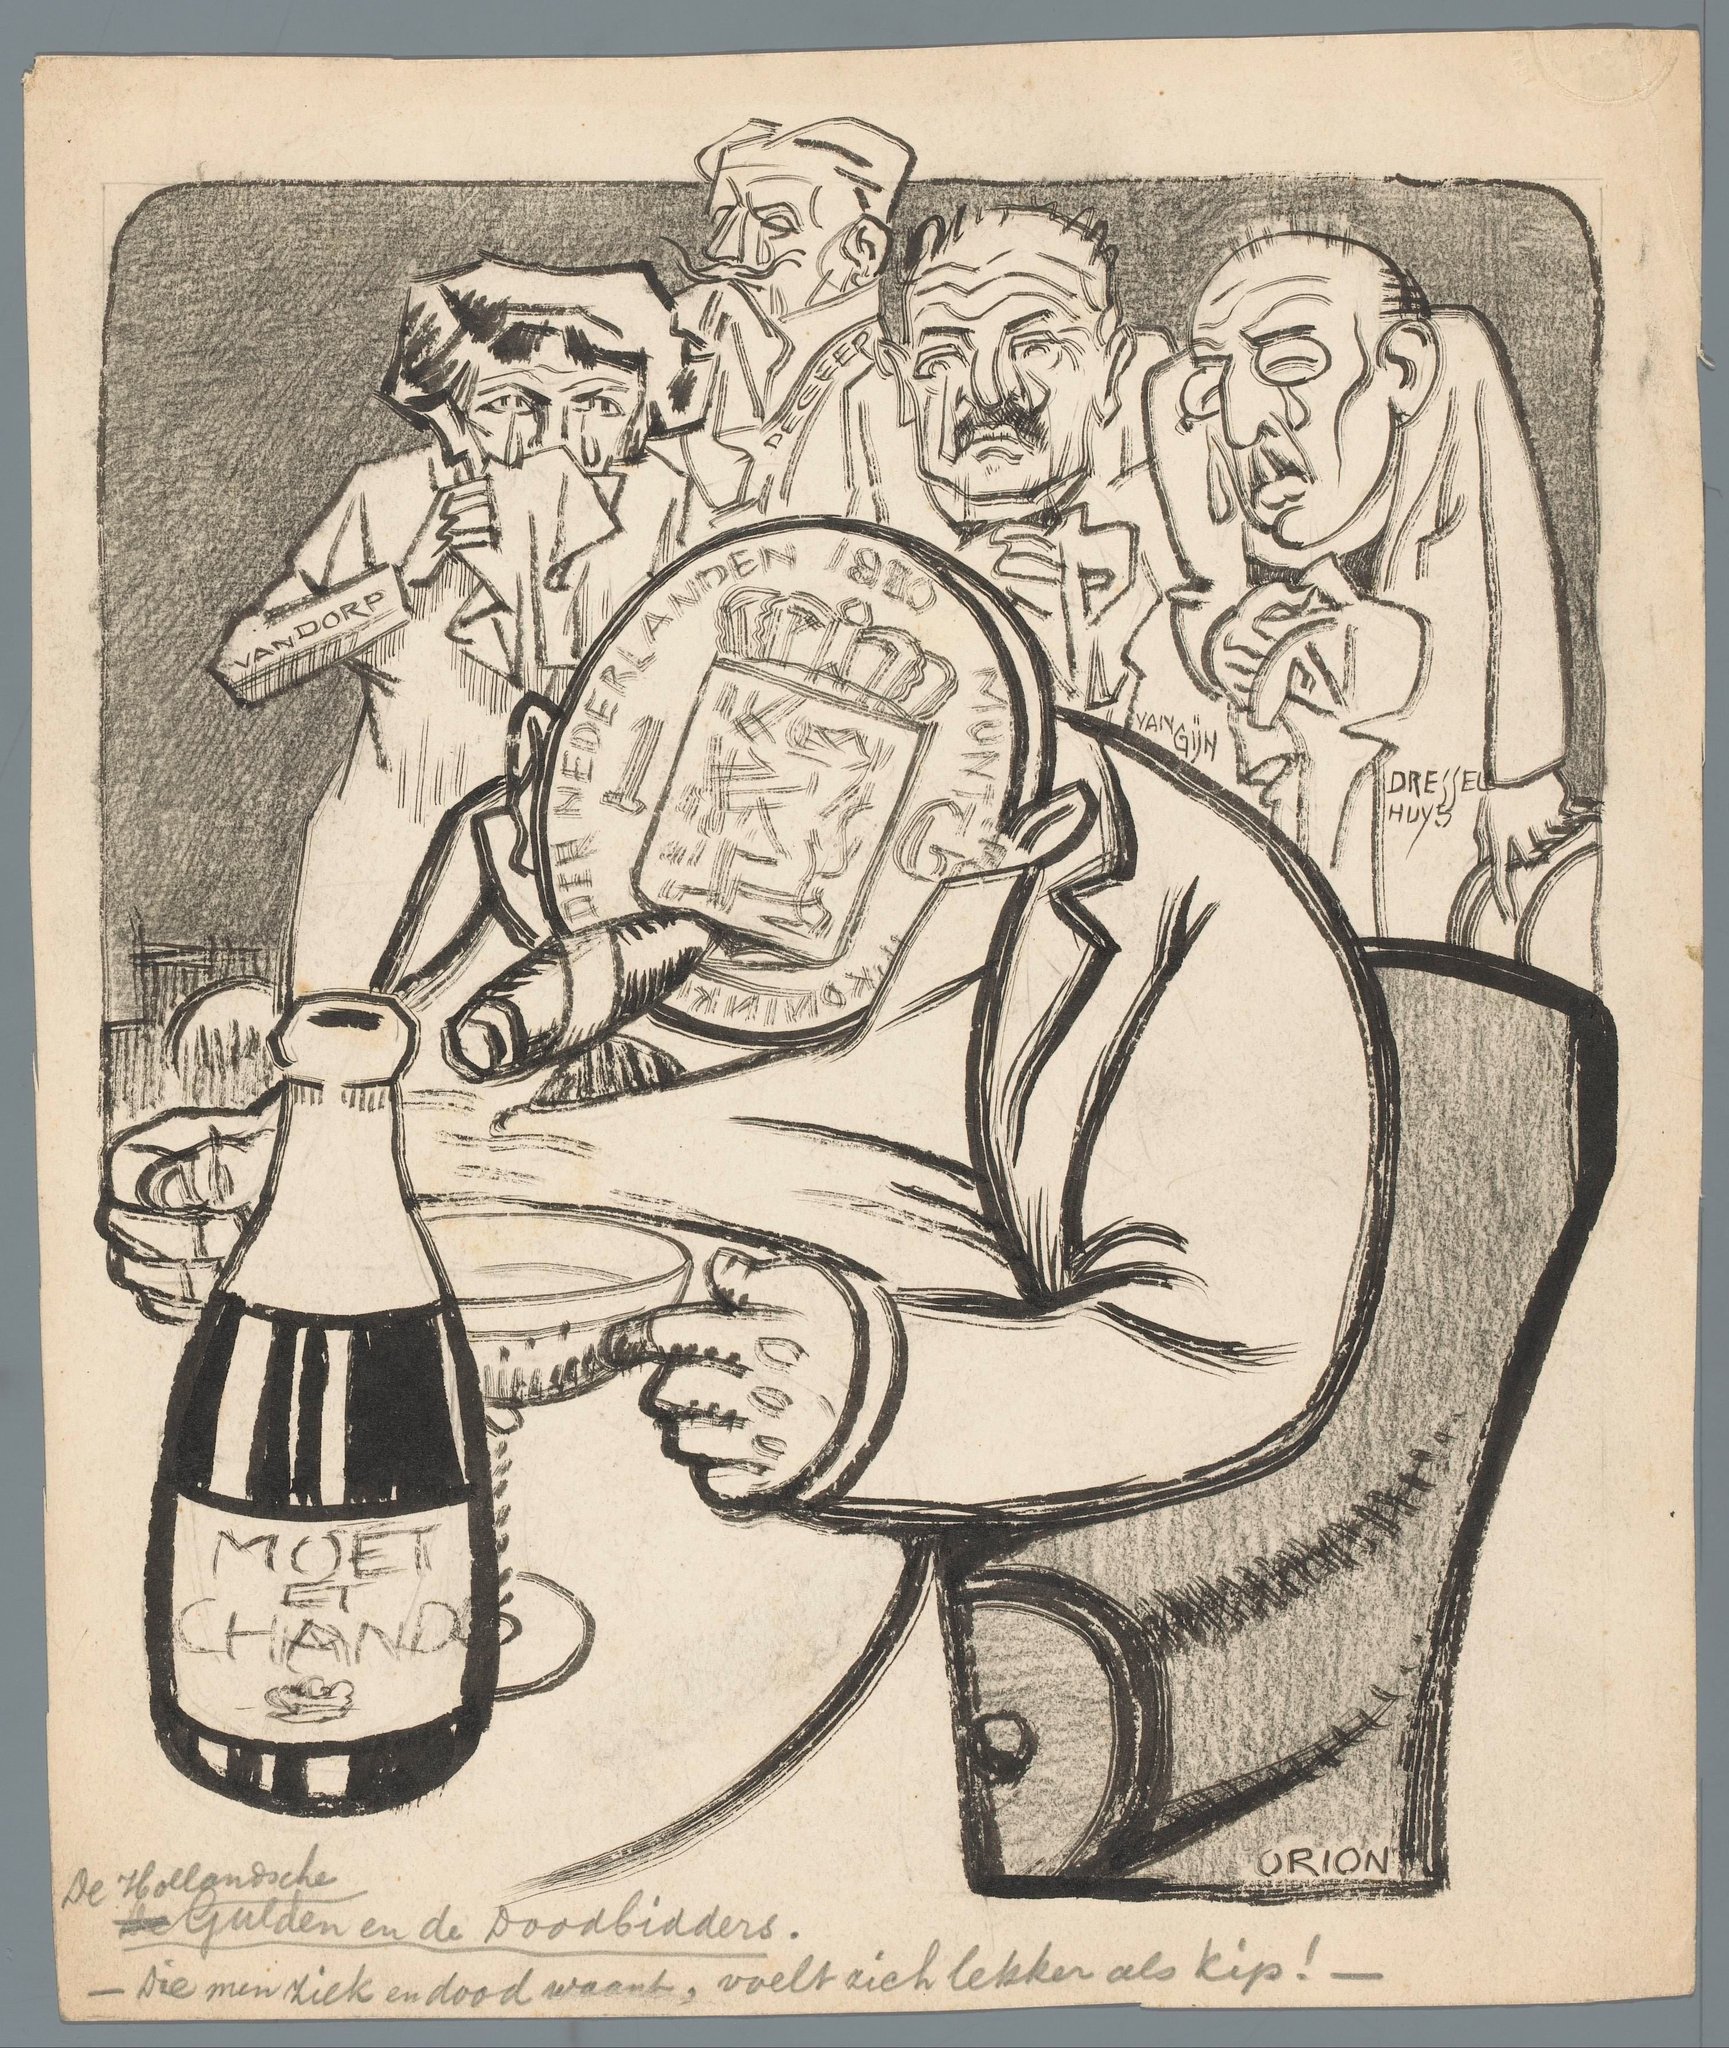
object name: drawing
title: Nederlandse Gulden in welstand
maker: patricq kroon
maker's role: draughtsman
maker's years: 1862-1941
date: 1922-1925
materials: chalk, ink, paper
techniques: pen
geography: netherlands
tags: politician, elisabeth carolina van dorp, political caricatures and satires, netherlands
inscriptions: inscription: ‘De Hollandsche Gulden en de Doodbidders / Die men ziek en dood waant, voelt zich lekker als kip!’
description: De Nederlandse gulden als een gezette man met sigaar en glas champagne. Op de achtergrond huilende politici (Van Dorp, De Geer, Van Gijn, Dresselhuijs). Ontwerp voor een politieke spotprent.